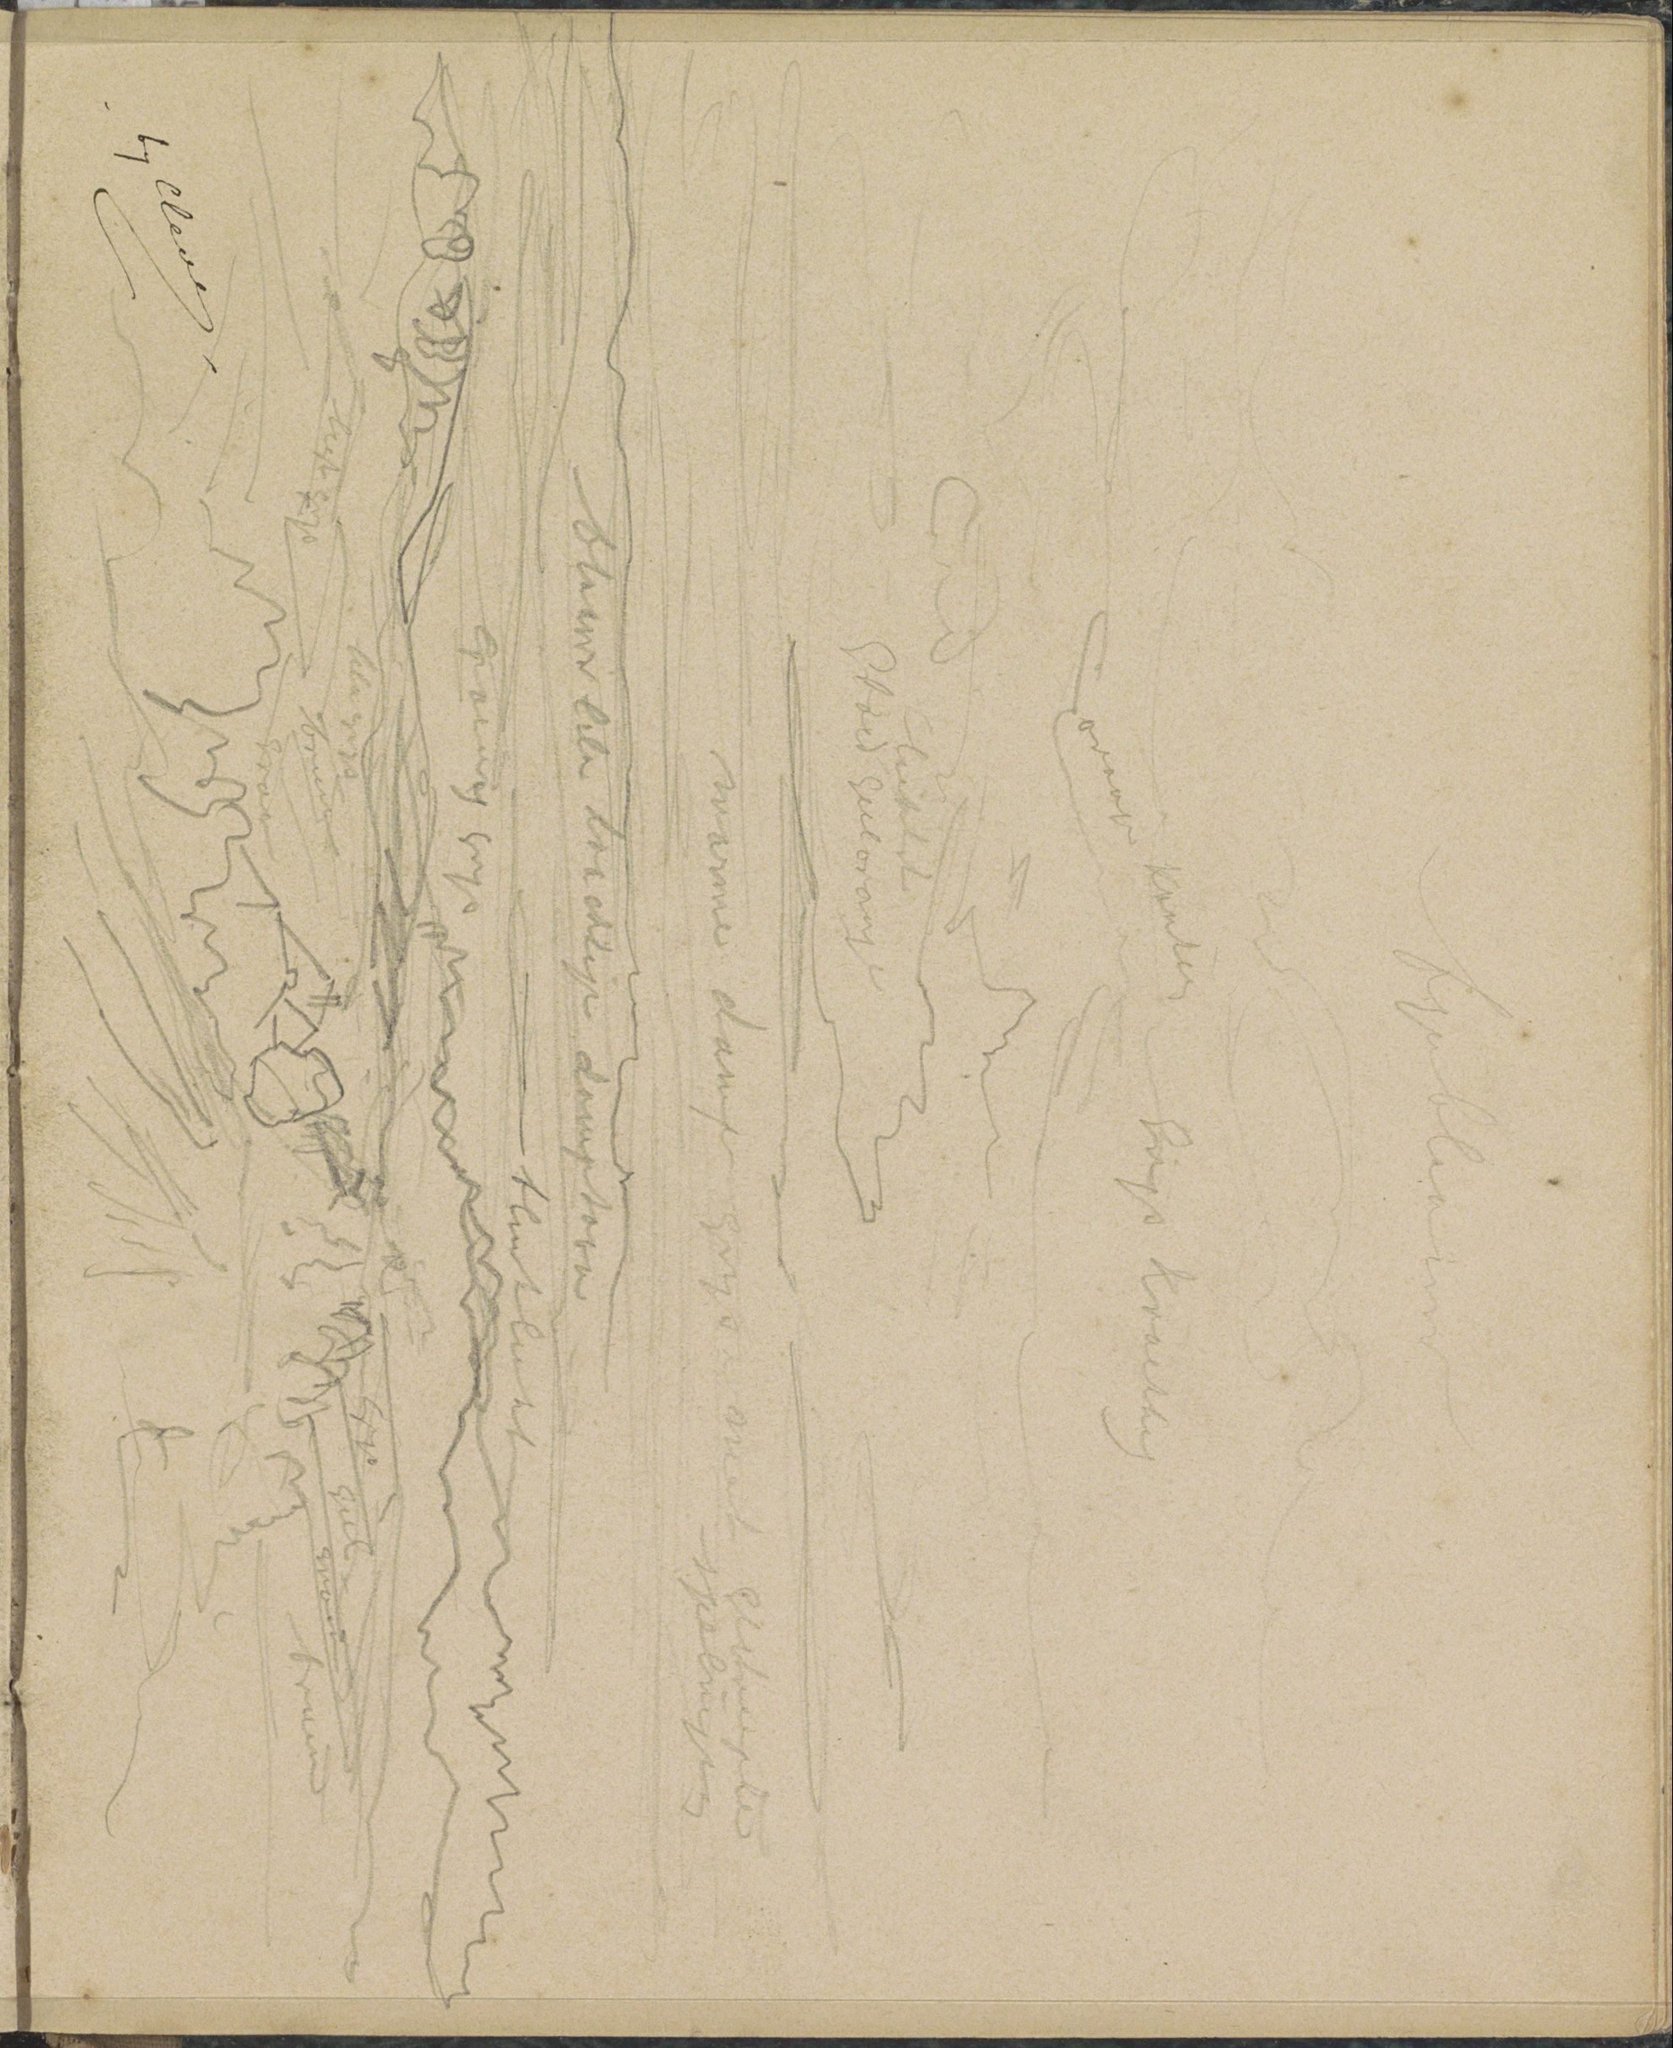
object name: sketchbook leaf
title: Landschap bij Kleef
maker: johannes tavenraat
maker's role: draughtsman, painter, print maker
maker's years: 1809-1881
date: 1841-1853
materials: paper, pencil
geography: cleves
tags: landscapes, clouds, cleves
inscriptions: annotation: ‘bij Cleve’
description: Blad 67 recto uit een schetsboek met 87 bladen.